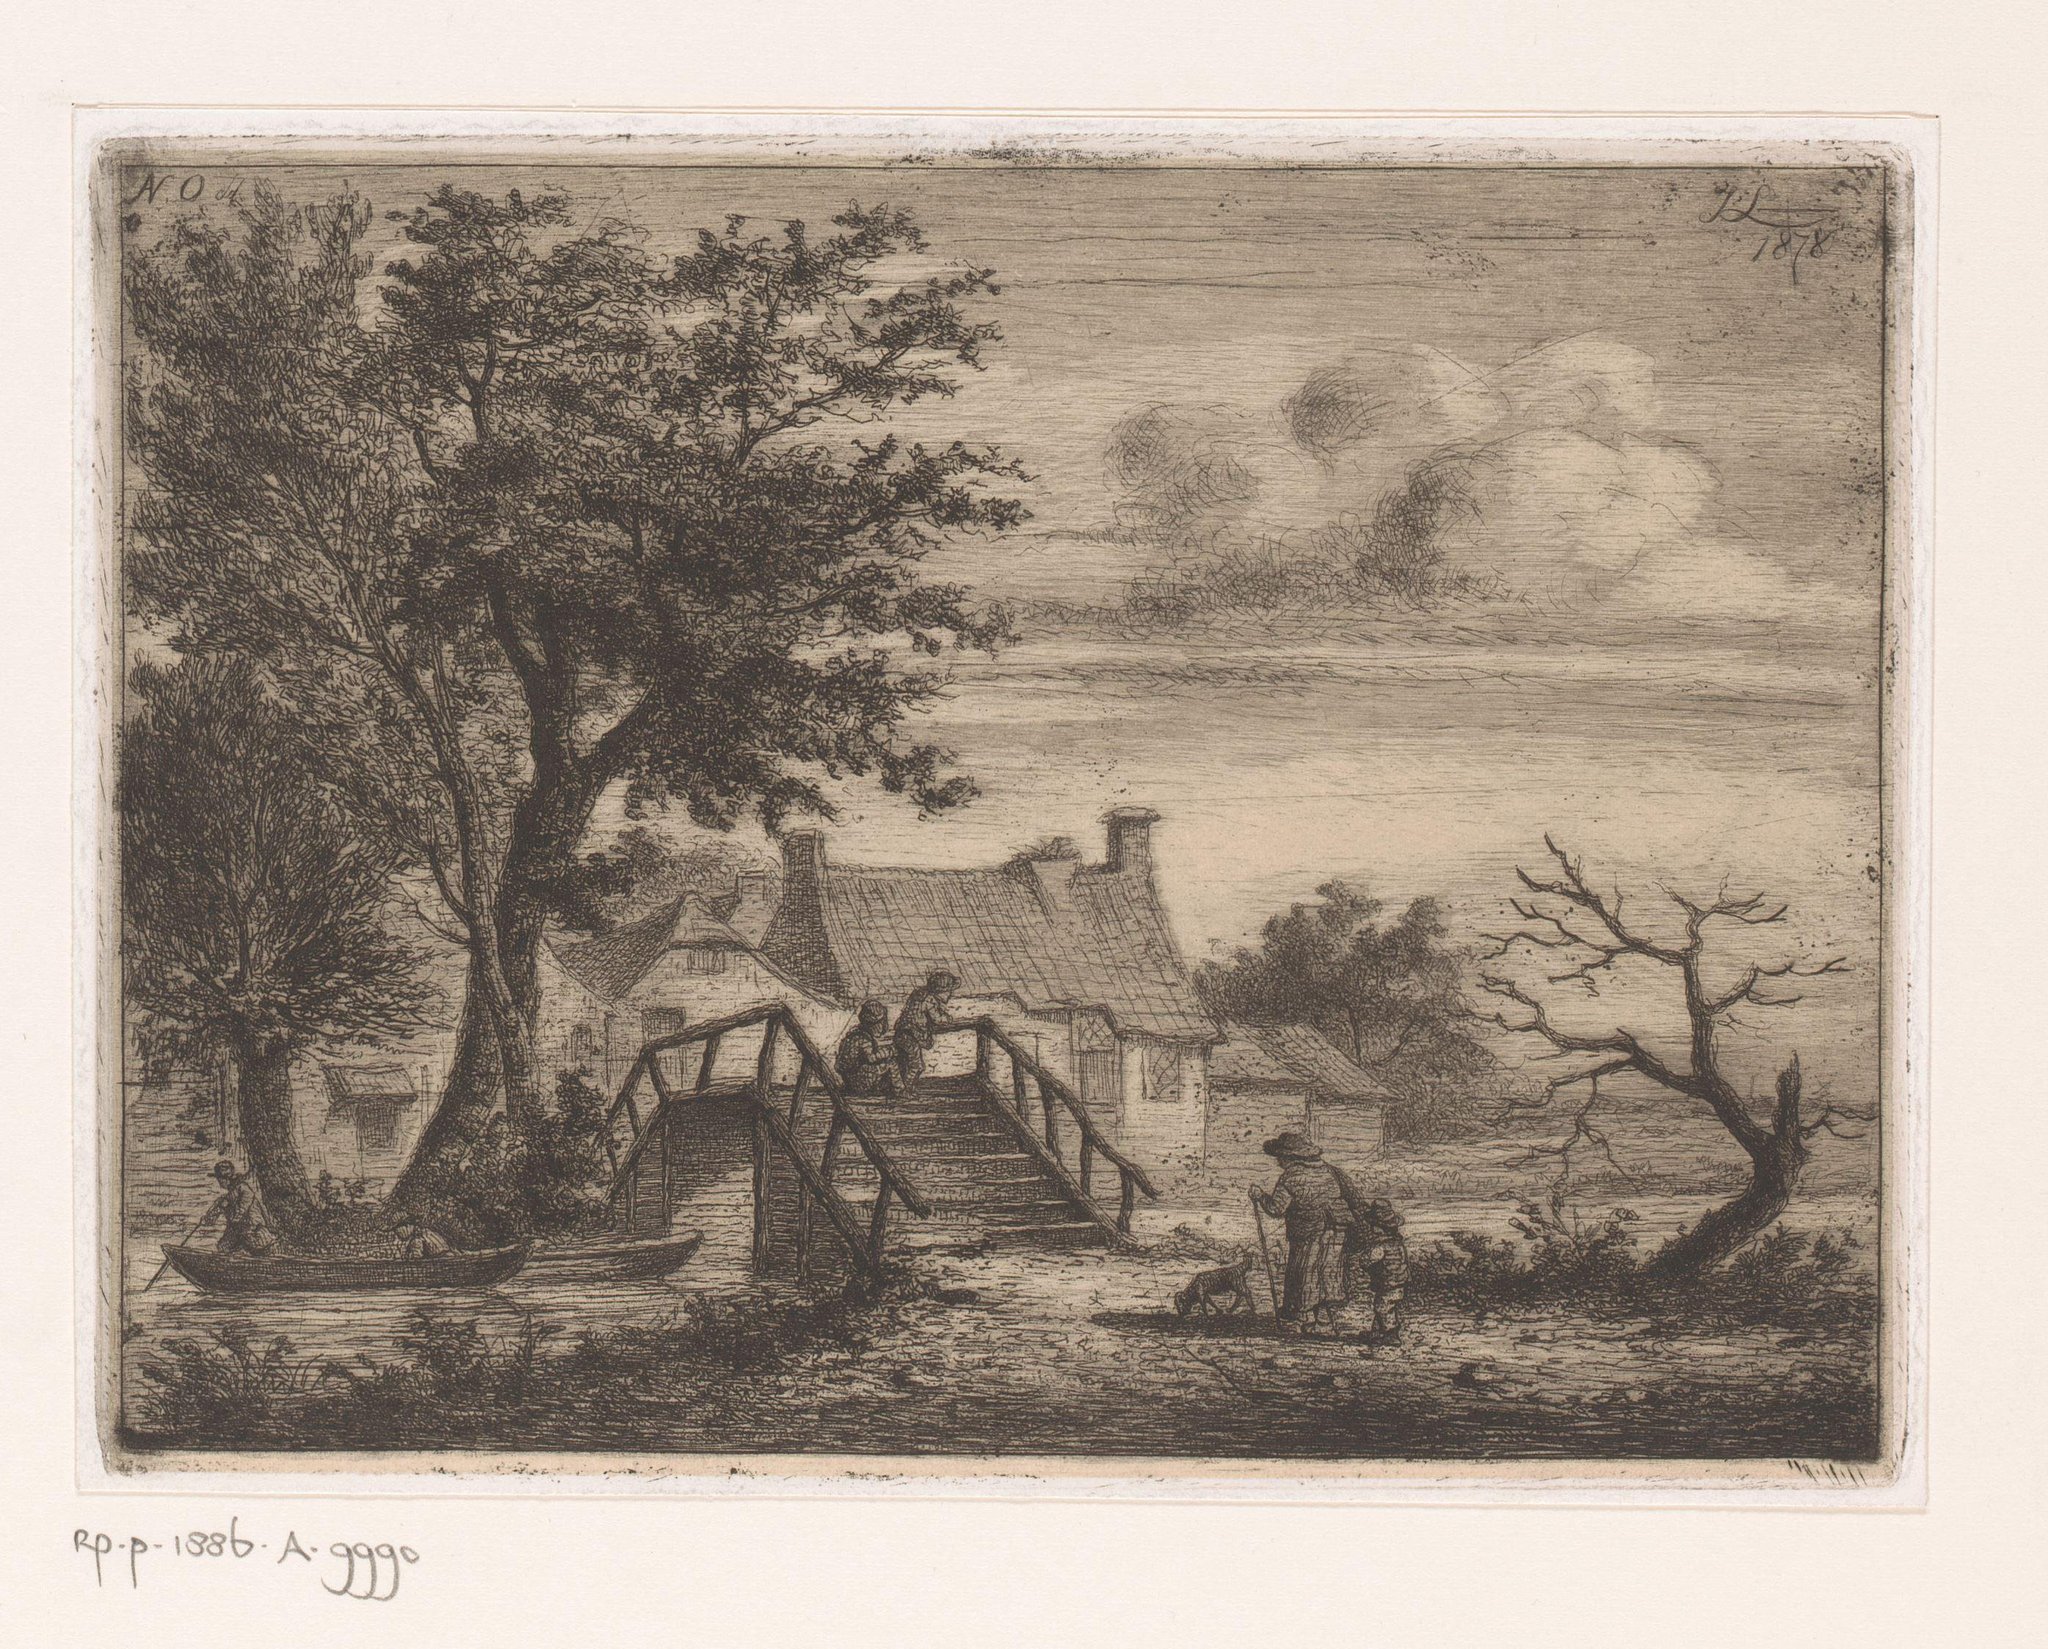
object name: print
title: Landschap met houten brug over een rivier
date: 1878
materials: paper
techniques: etching, intaglio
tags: poling, punting, bridge in city across river, canal, etc., dog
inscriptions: collector's mark: Lugt 2228